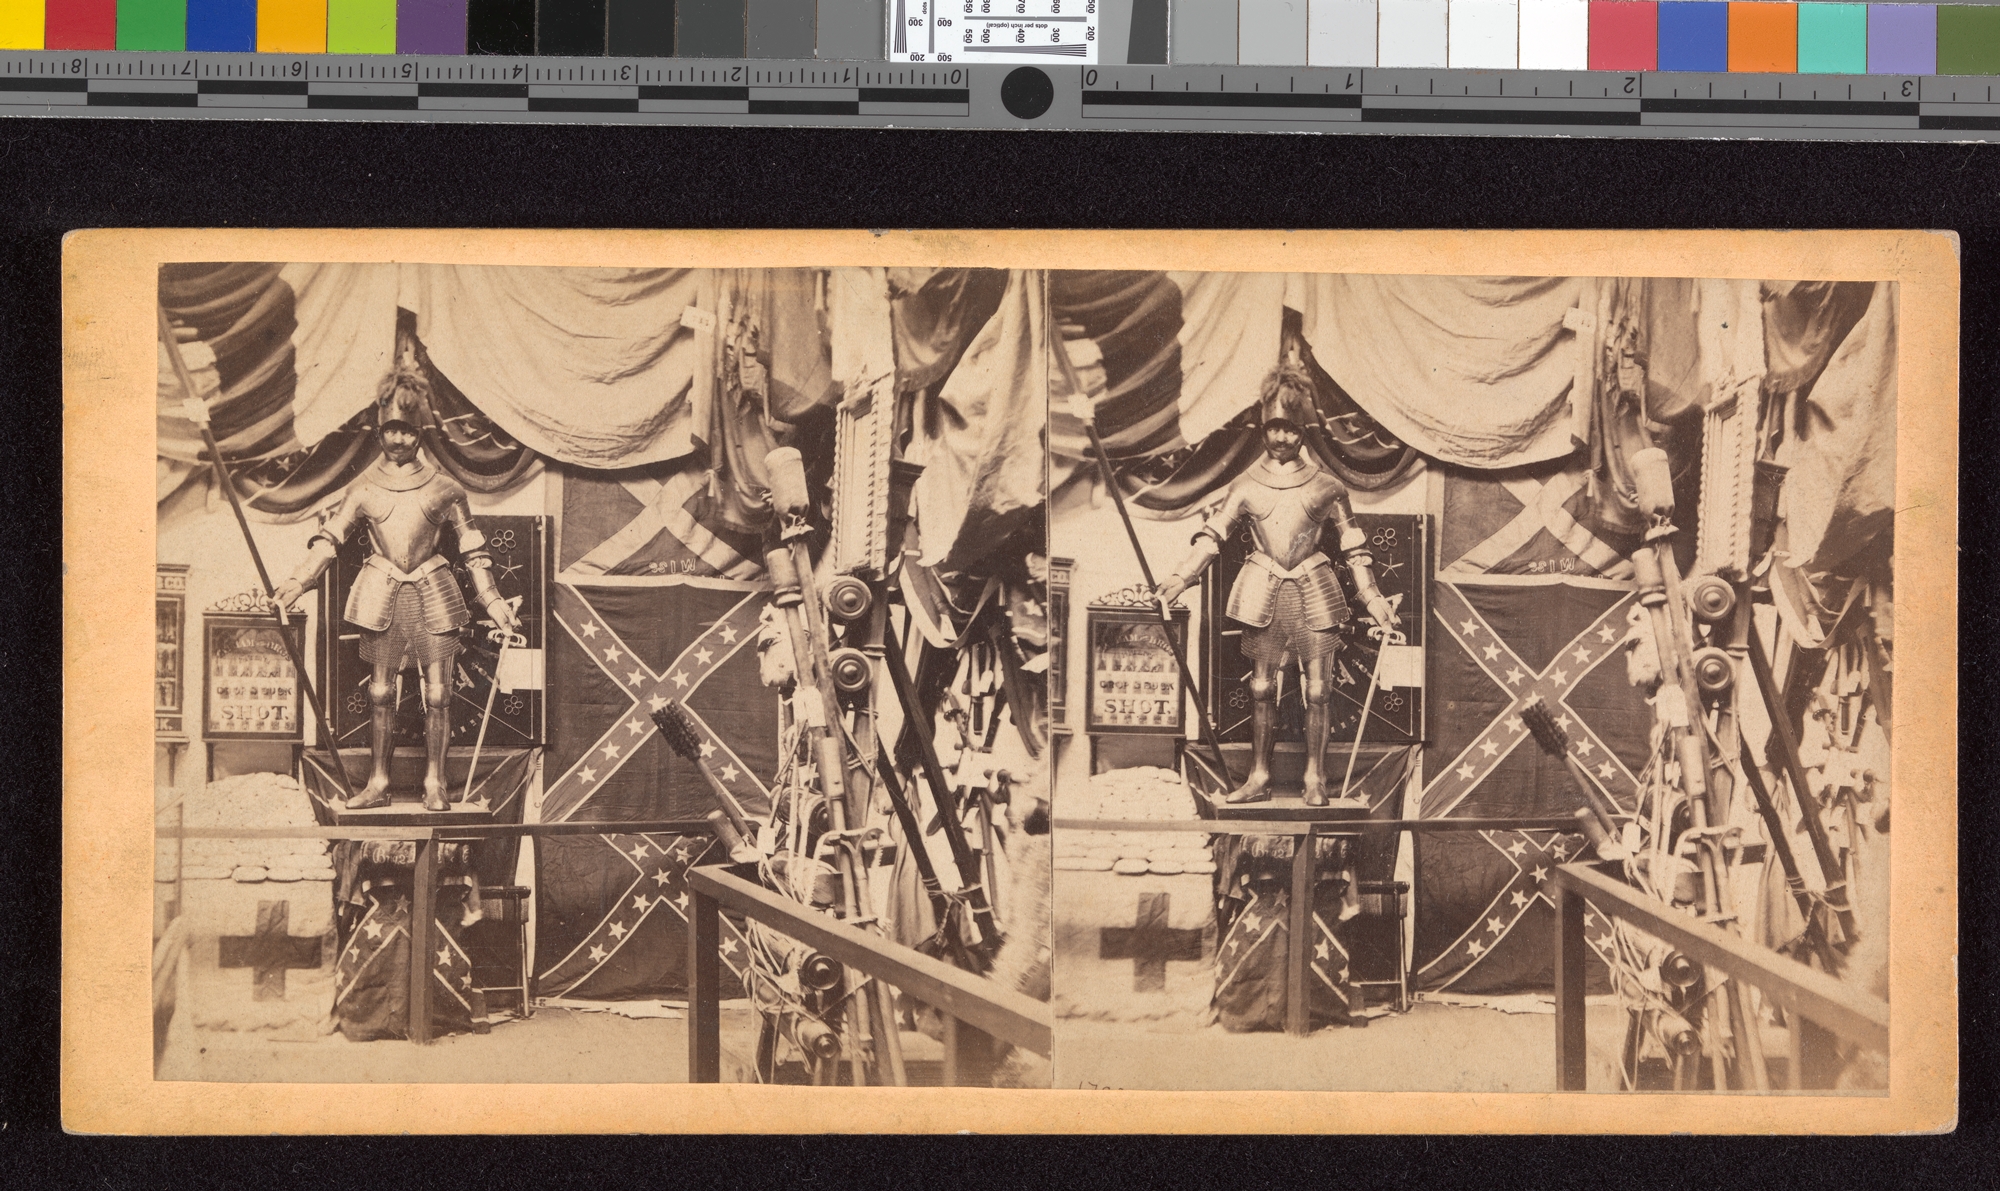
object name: stereograph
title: [225 Stereographs of United States Architecture]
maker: various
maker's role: artist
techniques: albumen silver print